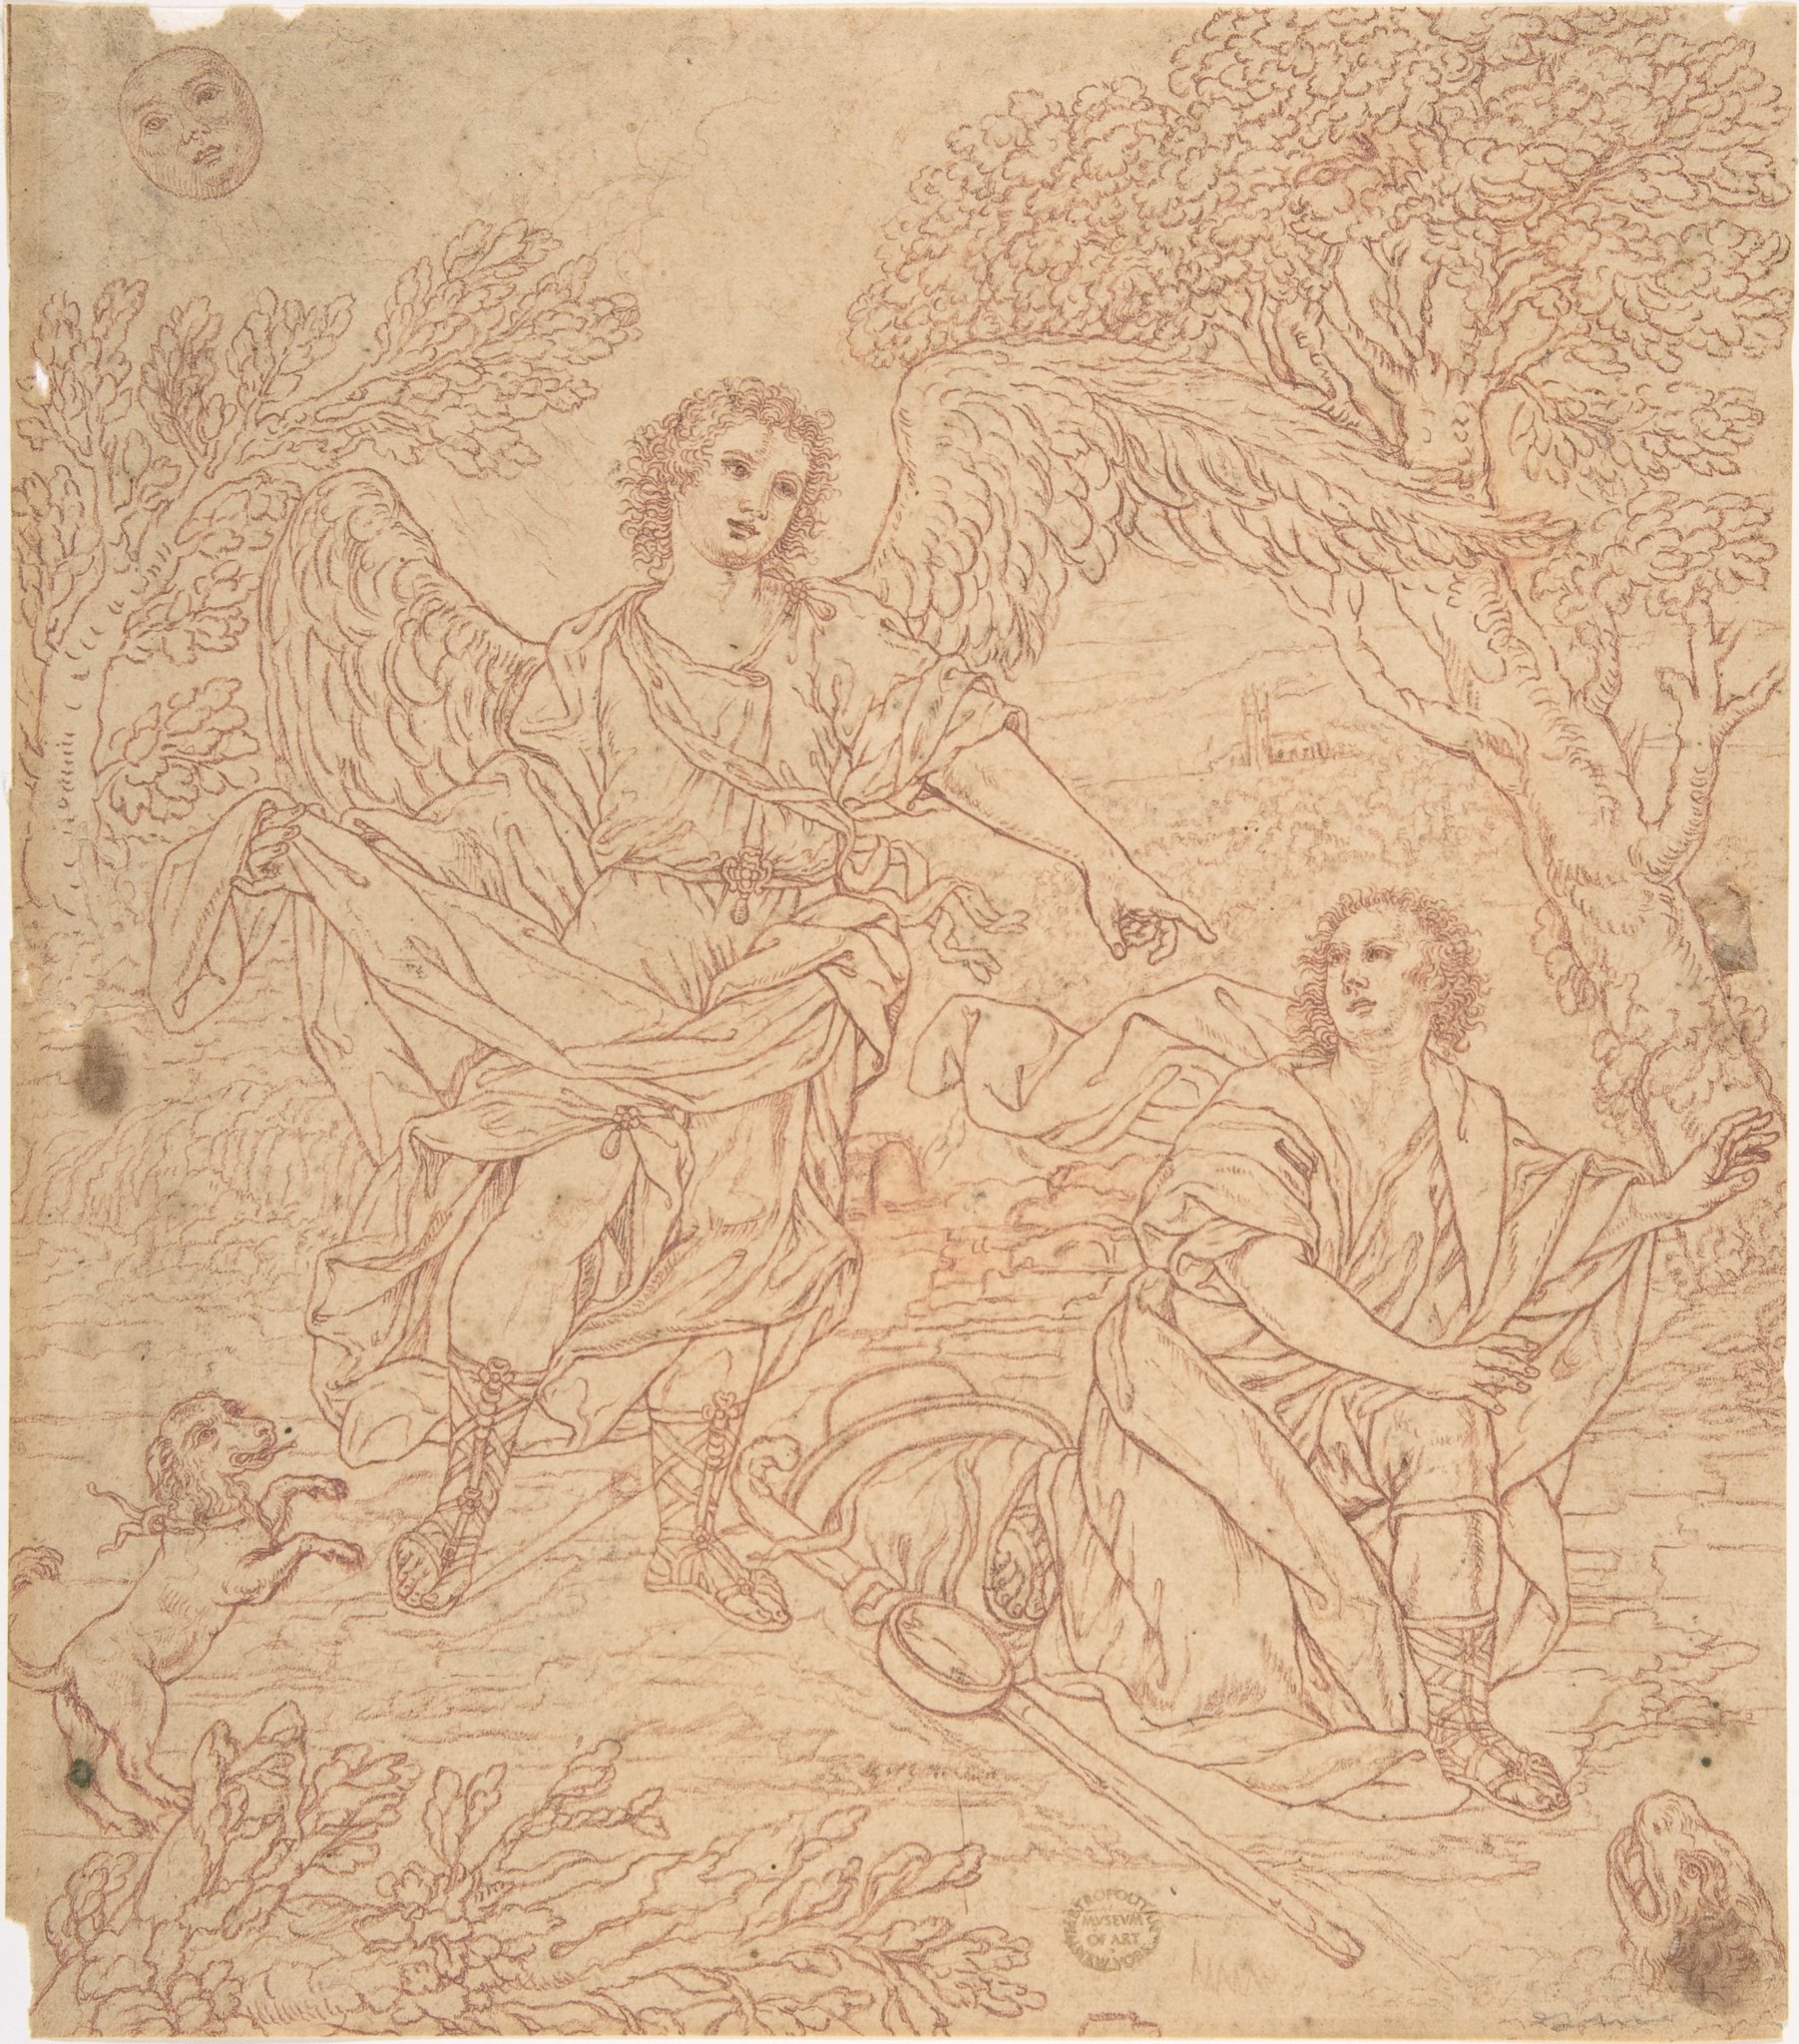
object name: drawing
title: Tobias and the Angel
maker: anonymous, italian, roman-bolognese, 17th century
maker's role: artist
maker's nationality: italian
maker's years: 1600-1700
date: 1601-1700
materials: chalk, paper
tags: men,dogs,angels